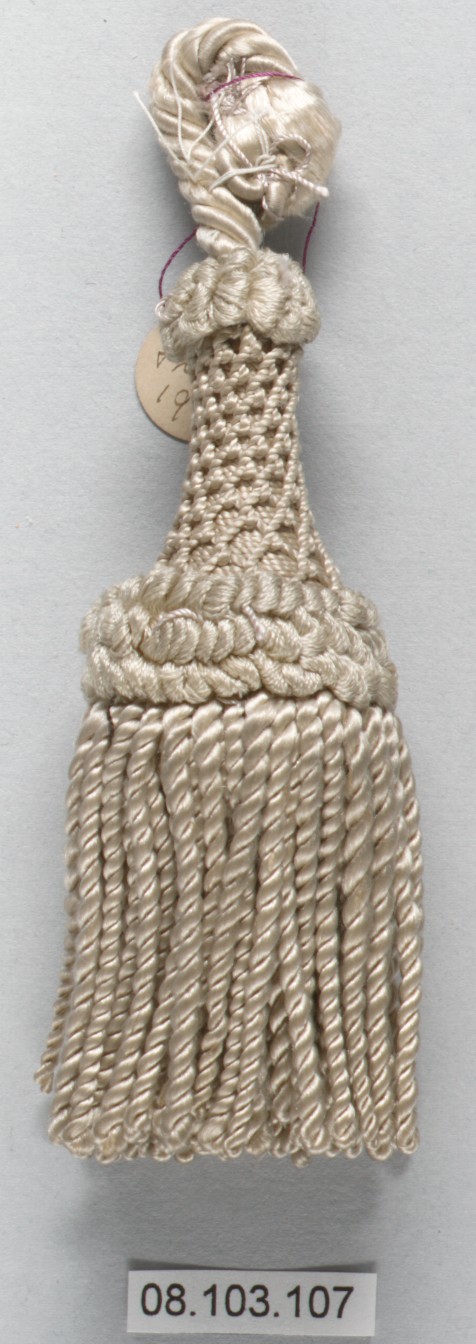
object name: tassel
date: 1801-1900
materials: silk